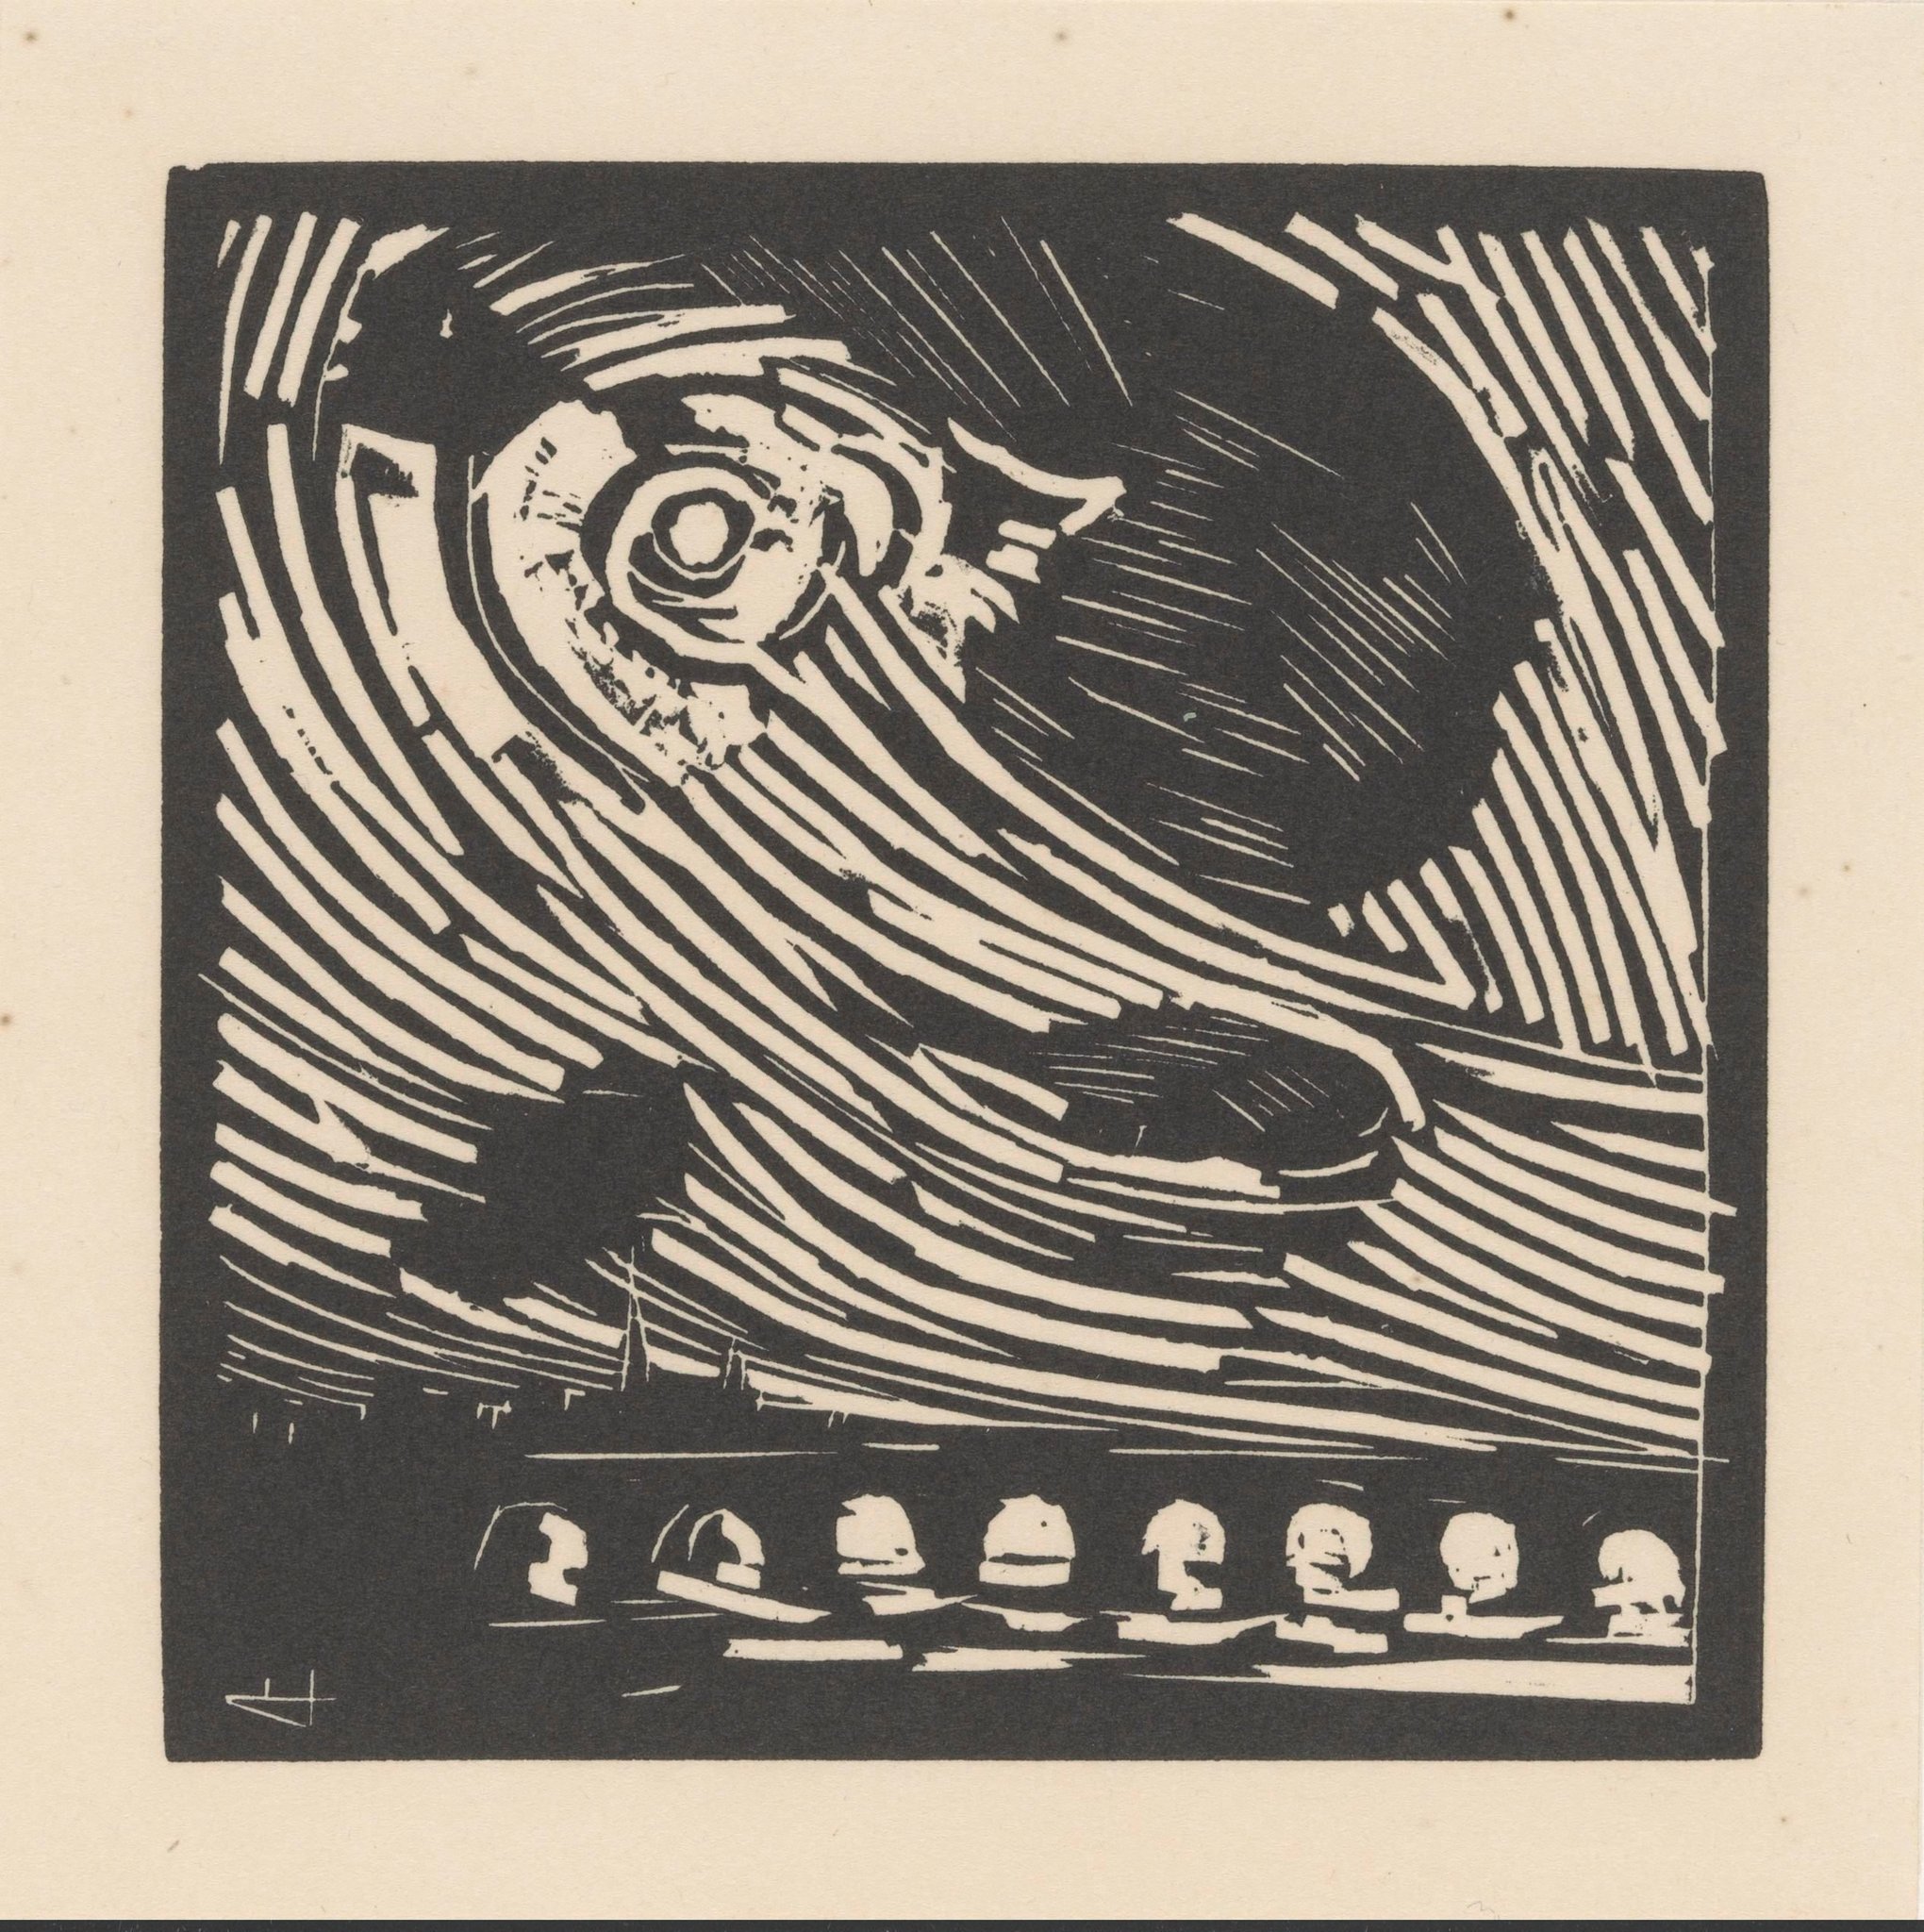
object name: print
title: Boogbrug, mogelijk de Sint Servaasbrug over de Maas in Maastricht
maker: henri jonas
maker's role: draughtsman, print maker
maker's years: 1878-1944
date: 1888-1931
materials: paper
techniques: woodcut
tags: parts of church exterior and annexes, bridge, maastricht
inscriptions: collector's mark: Lugt 2228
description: Met gezicht op het stadsdeel Wyck en silhouet van de Sint-Martinuskerk. Vanaf 1932 stond deze boogbrug bekend als de Sint-Servaasbrug.